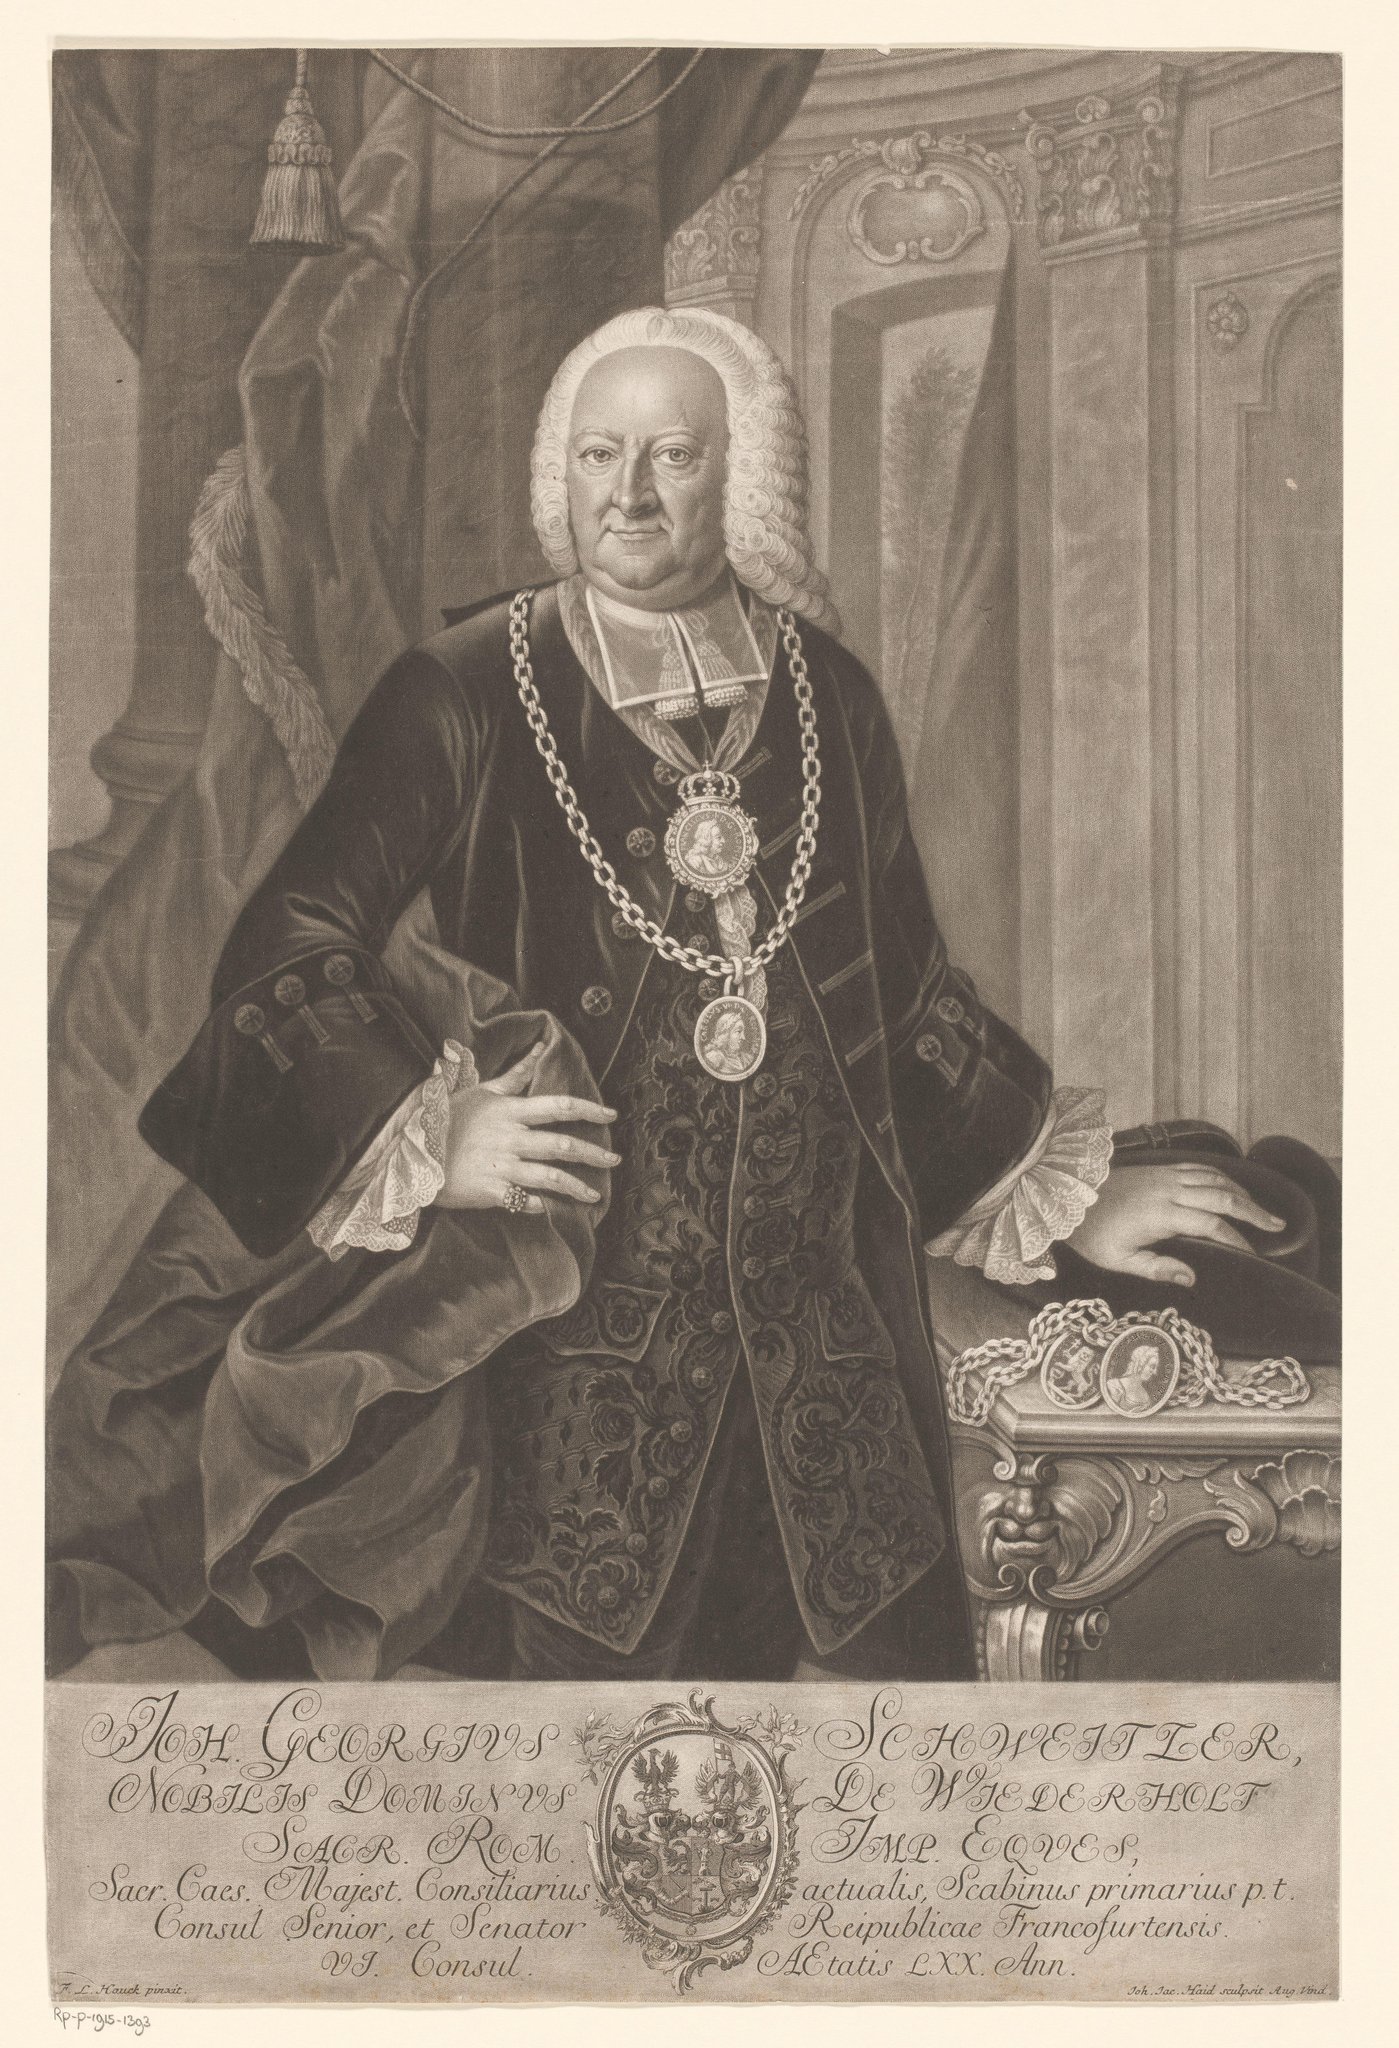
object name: print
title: Portret van Johann Georg Schweitzer op 70-jarige leeftijd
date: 1752-1767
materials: paper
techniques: etching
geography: augsburg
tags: official; civil servant; functionary (in general), historical persons, pendant, trinket, 'breloque', decorations, honours (as symbols of the state, etc.), armorial bearing, heraldry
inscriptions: collector's mark: Lugt 2228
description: Portret van de staatsman Johann Georg Schweitzer met twee ambtskettingen om de nek en twee op de tafel.